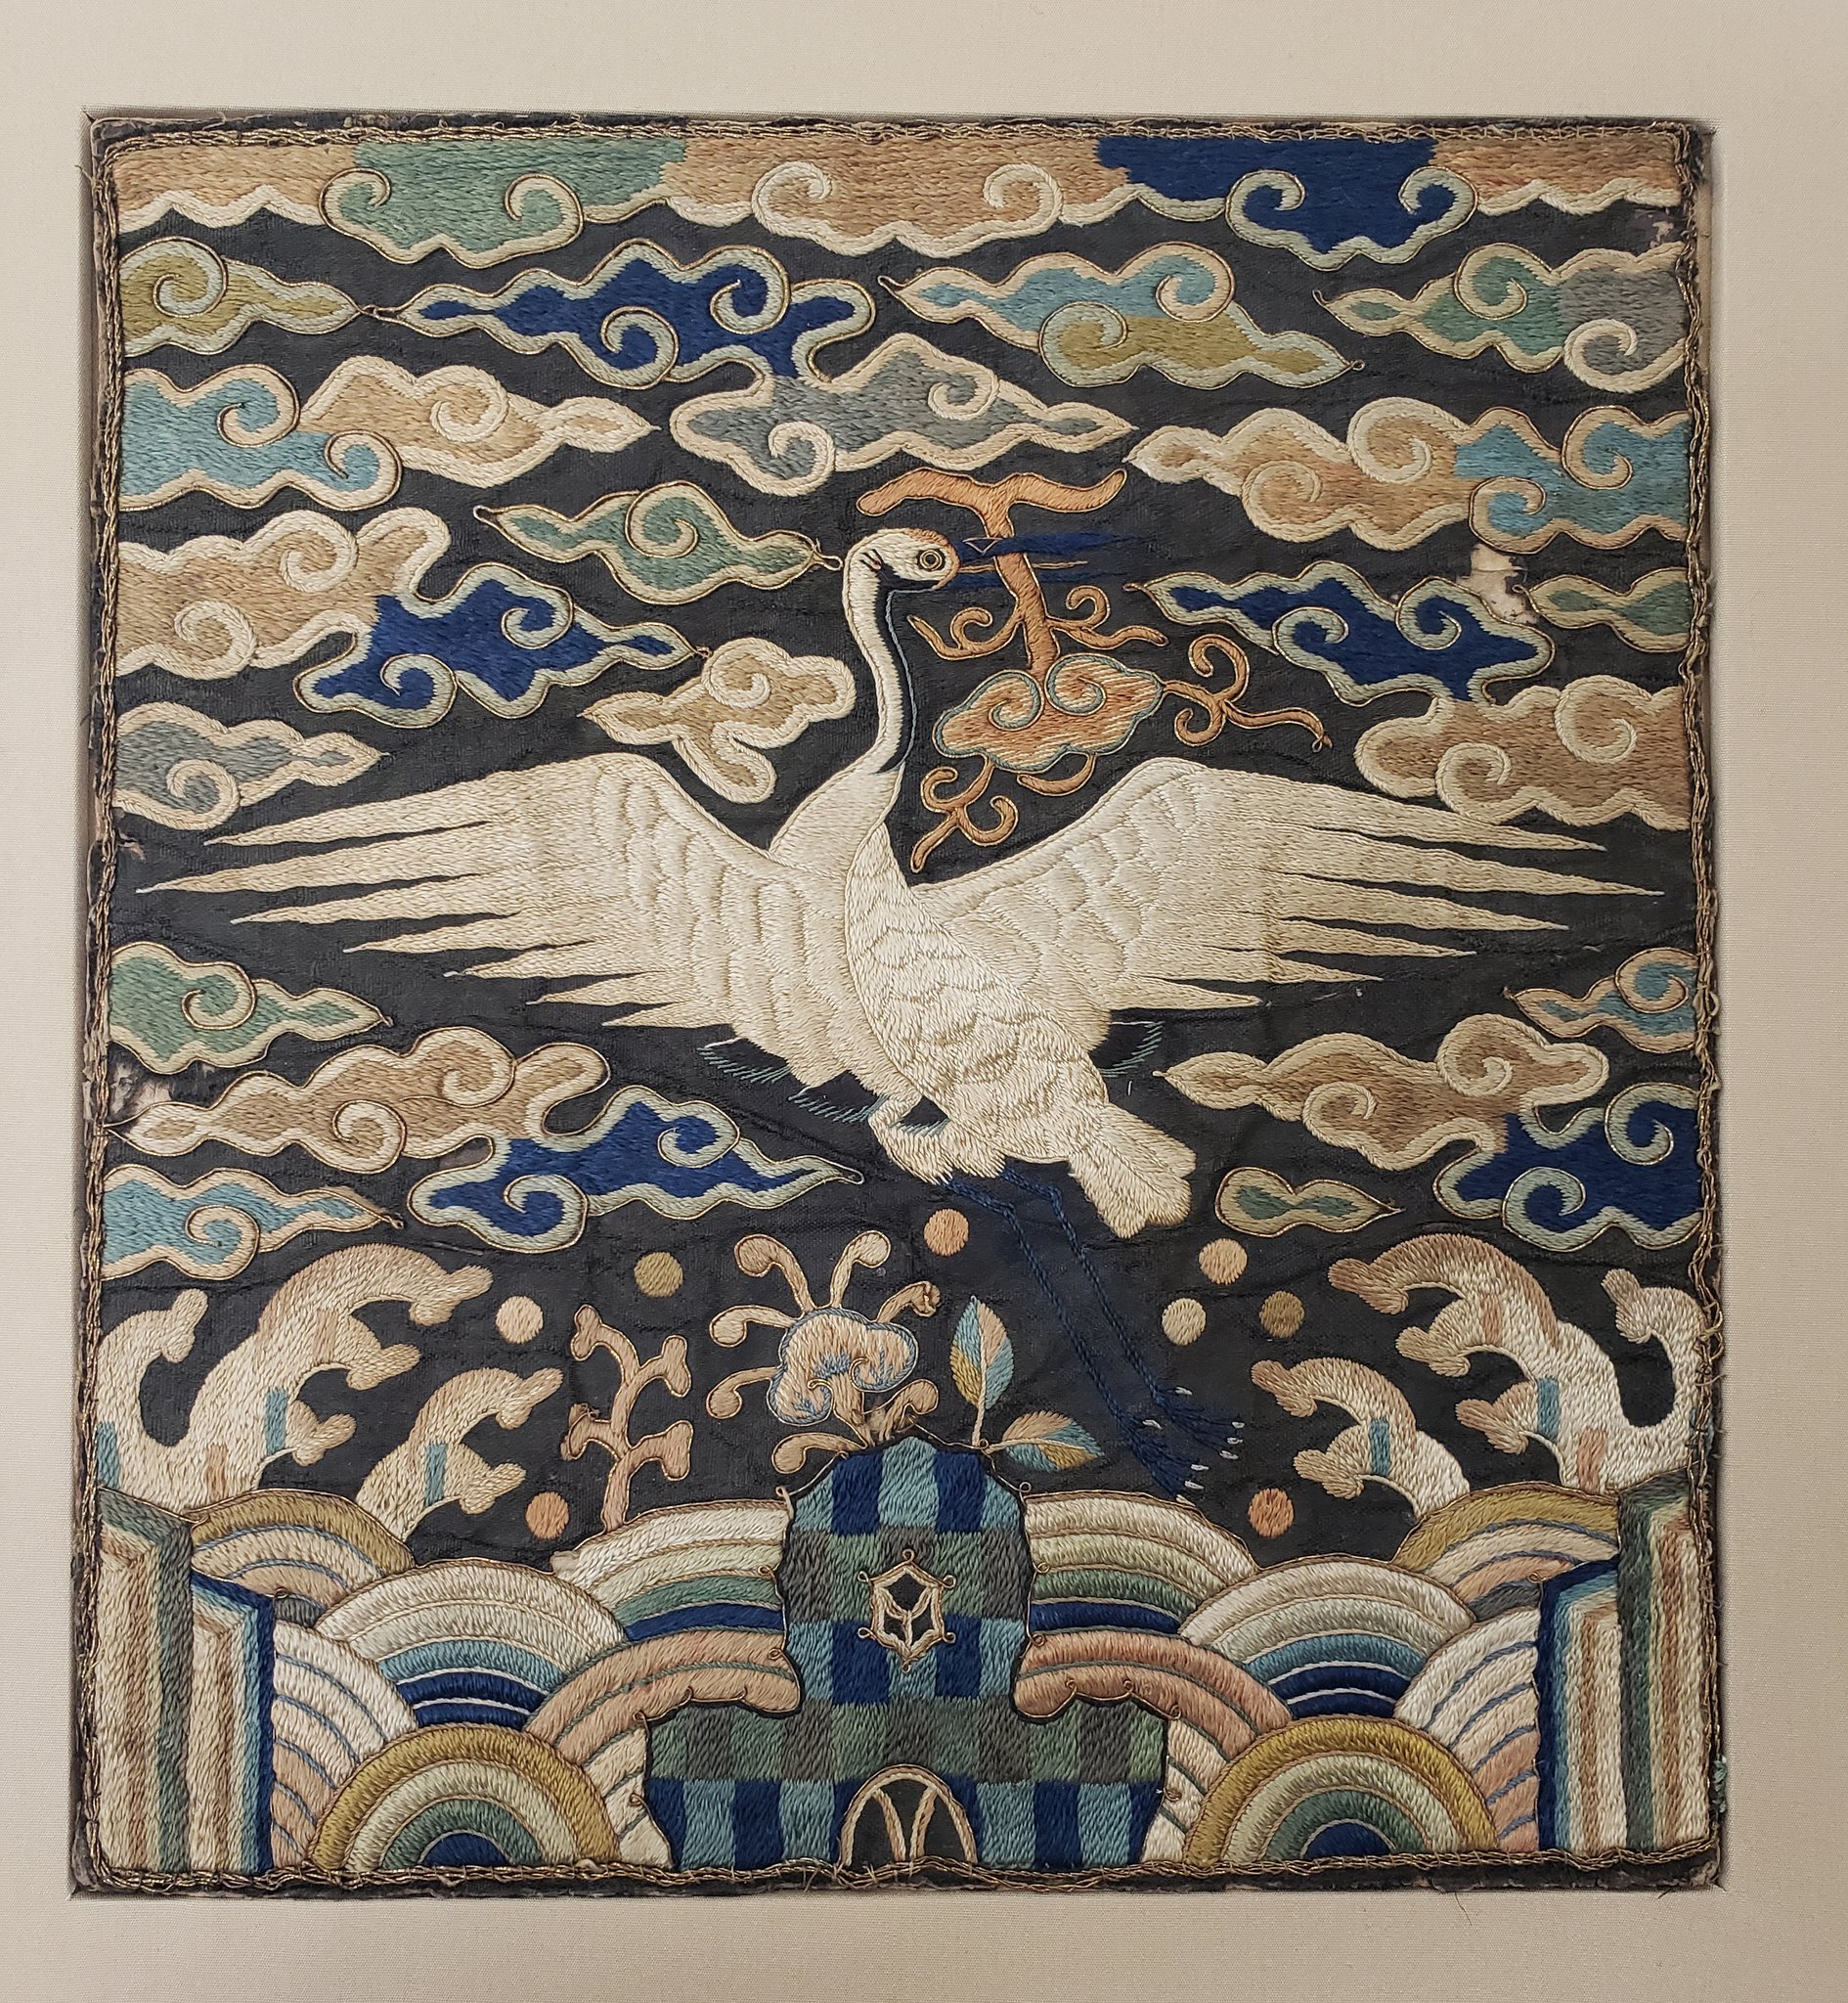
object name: rank badge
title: Rank badge with a crane (one of a pair)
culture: korean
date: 1867-1900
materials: metal thread, silk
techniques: damask, embroidery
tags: cranes